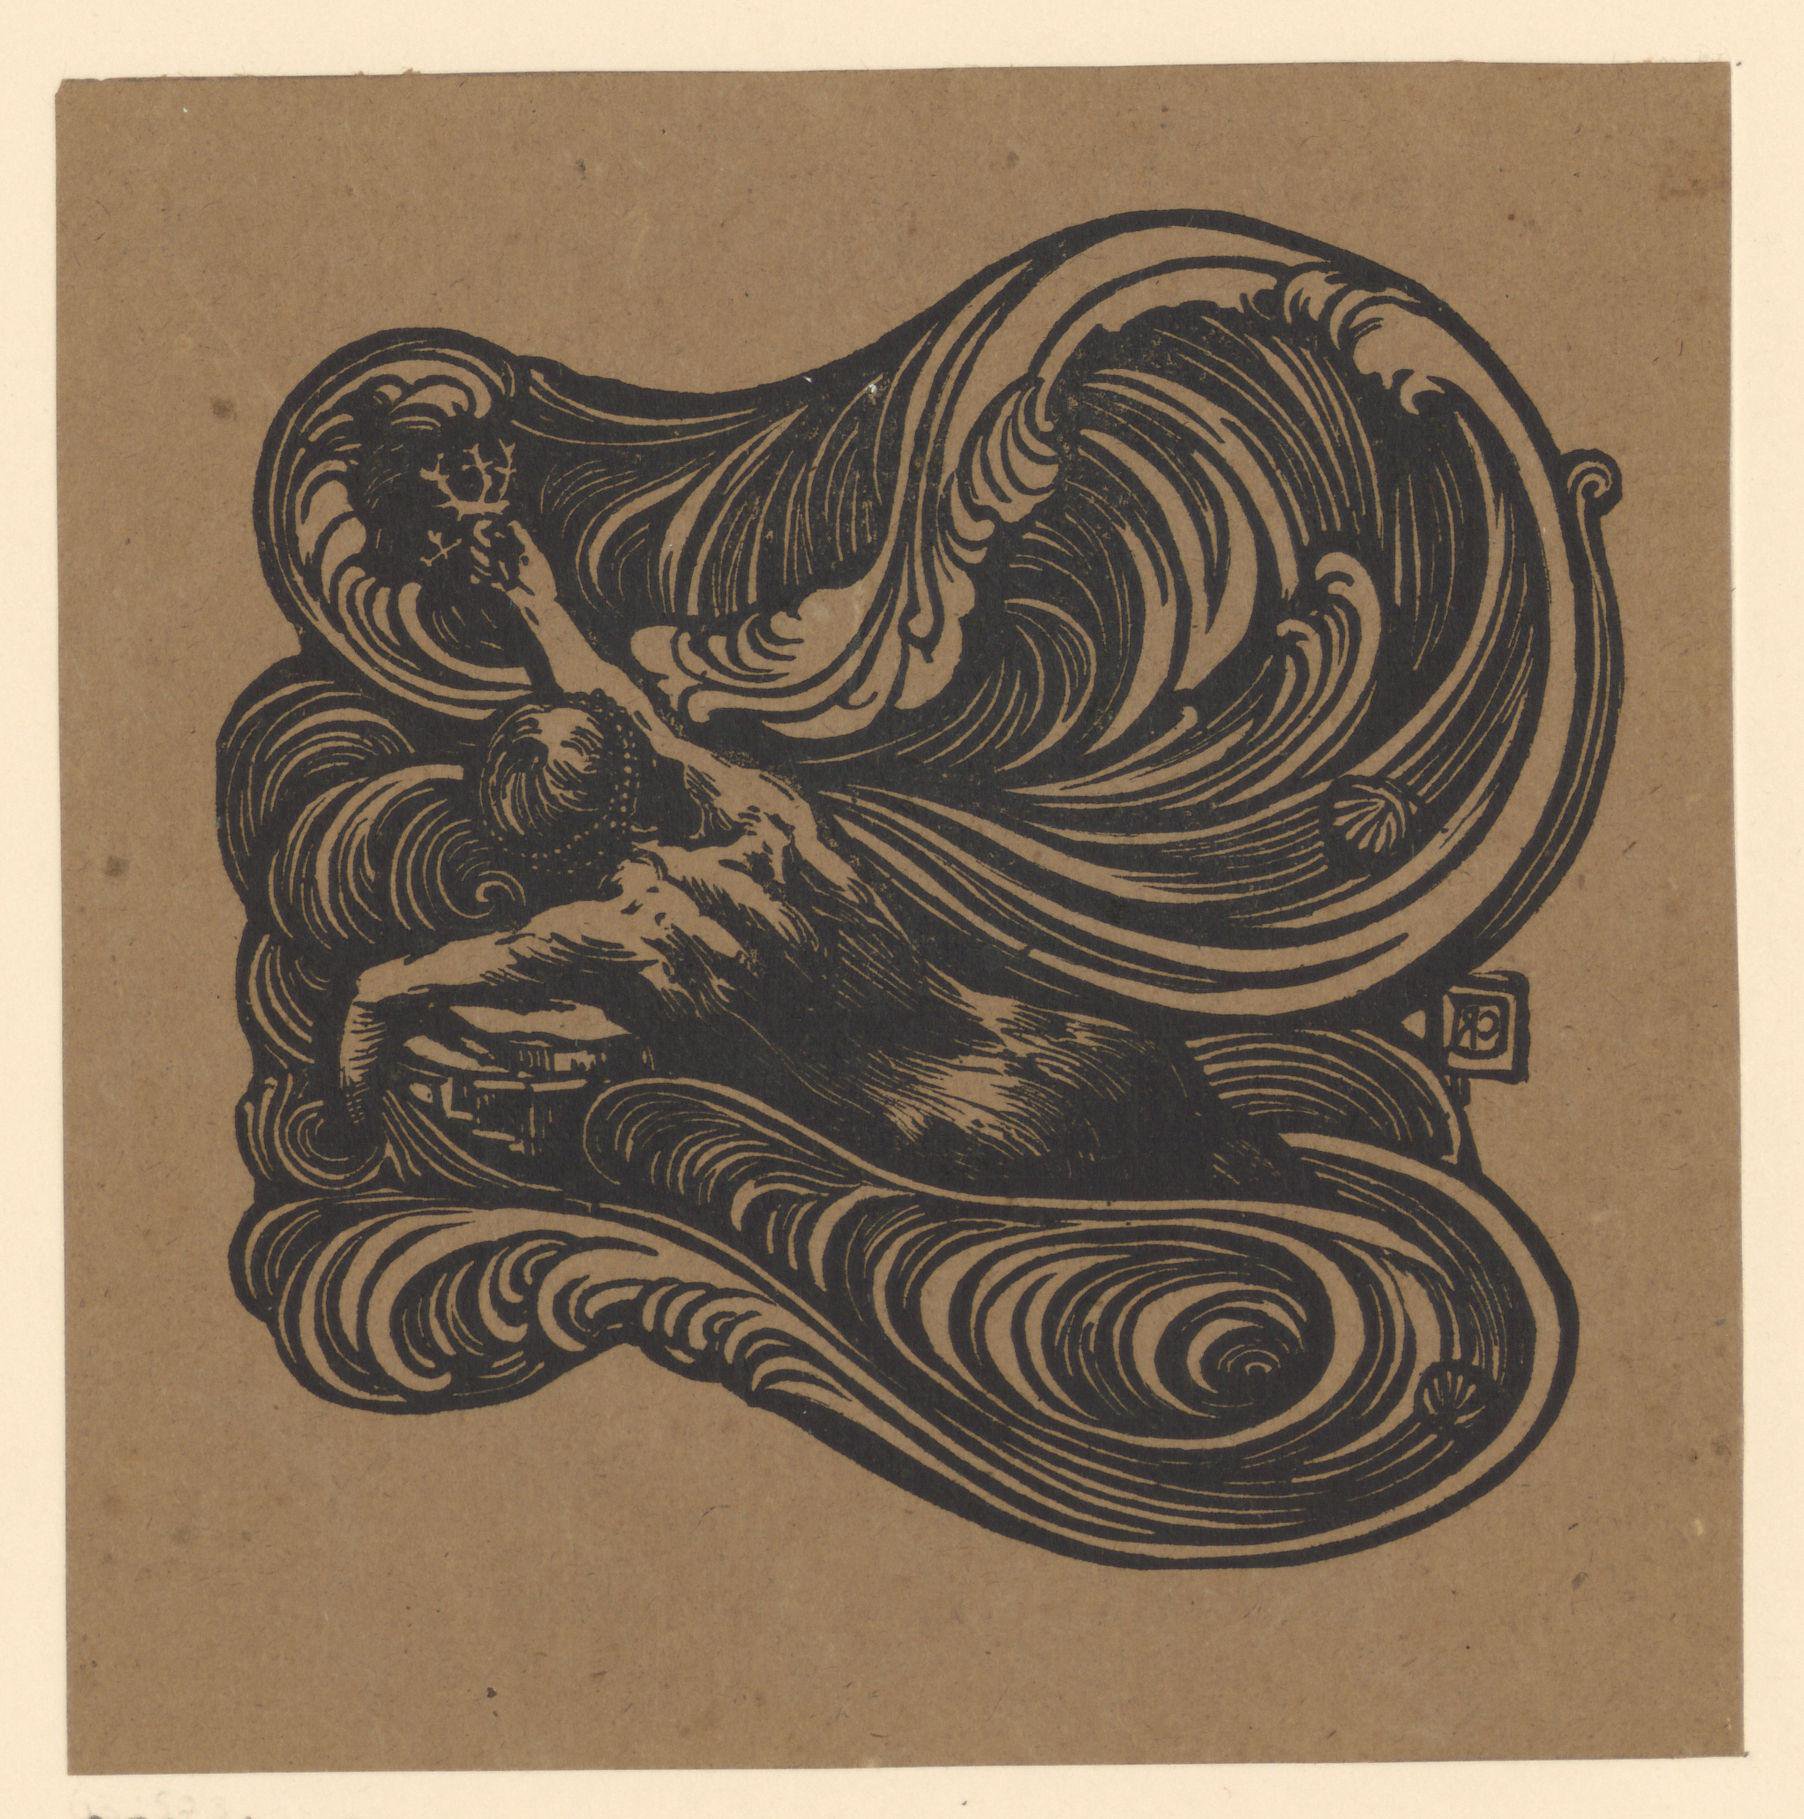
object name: print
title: Man zwemt in de golven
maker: charles ricketts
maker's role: print maker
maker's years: 1866-1931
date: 1892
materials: paper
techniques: woodcut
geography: london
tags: adult man, swimming (movement in water)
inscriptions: collector's mark: Lugt 2228